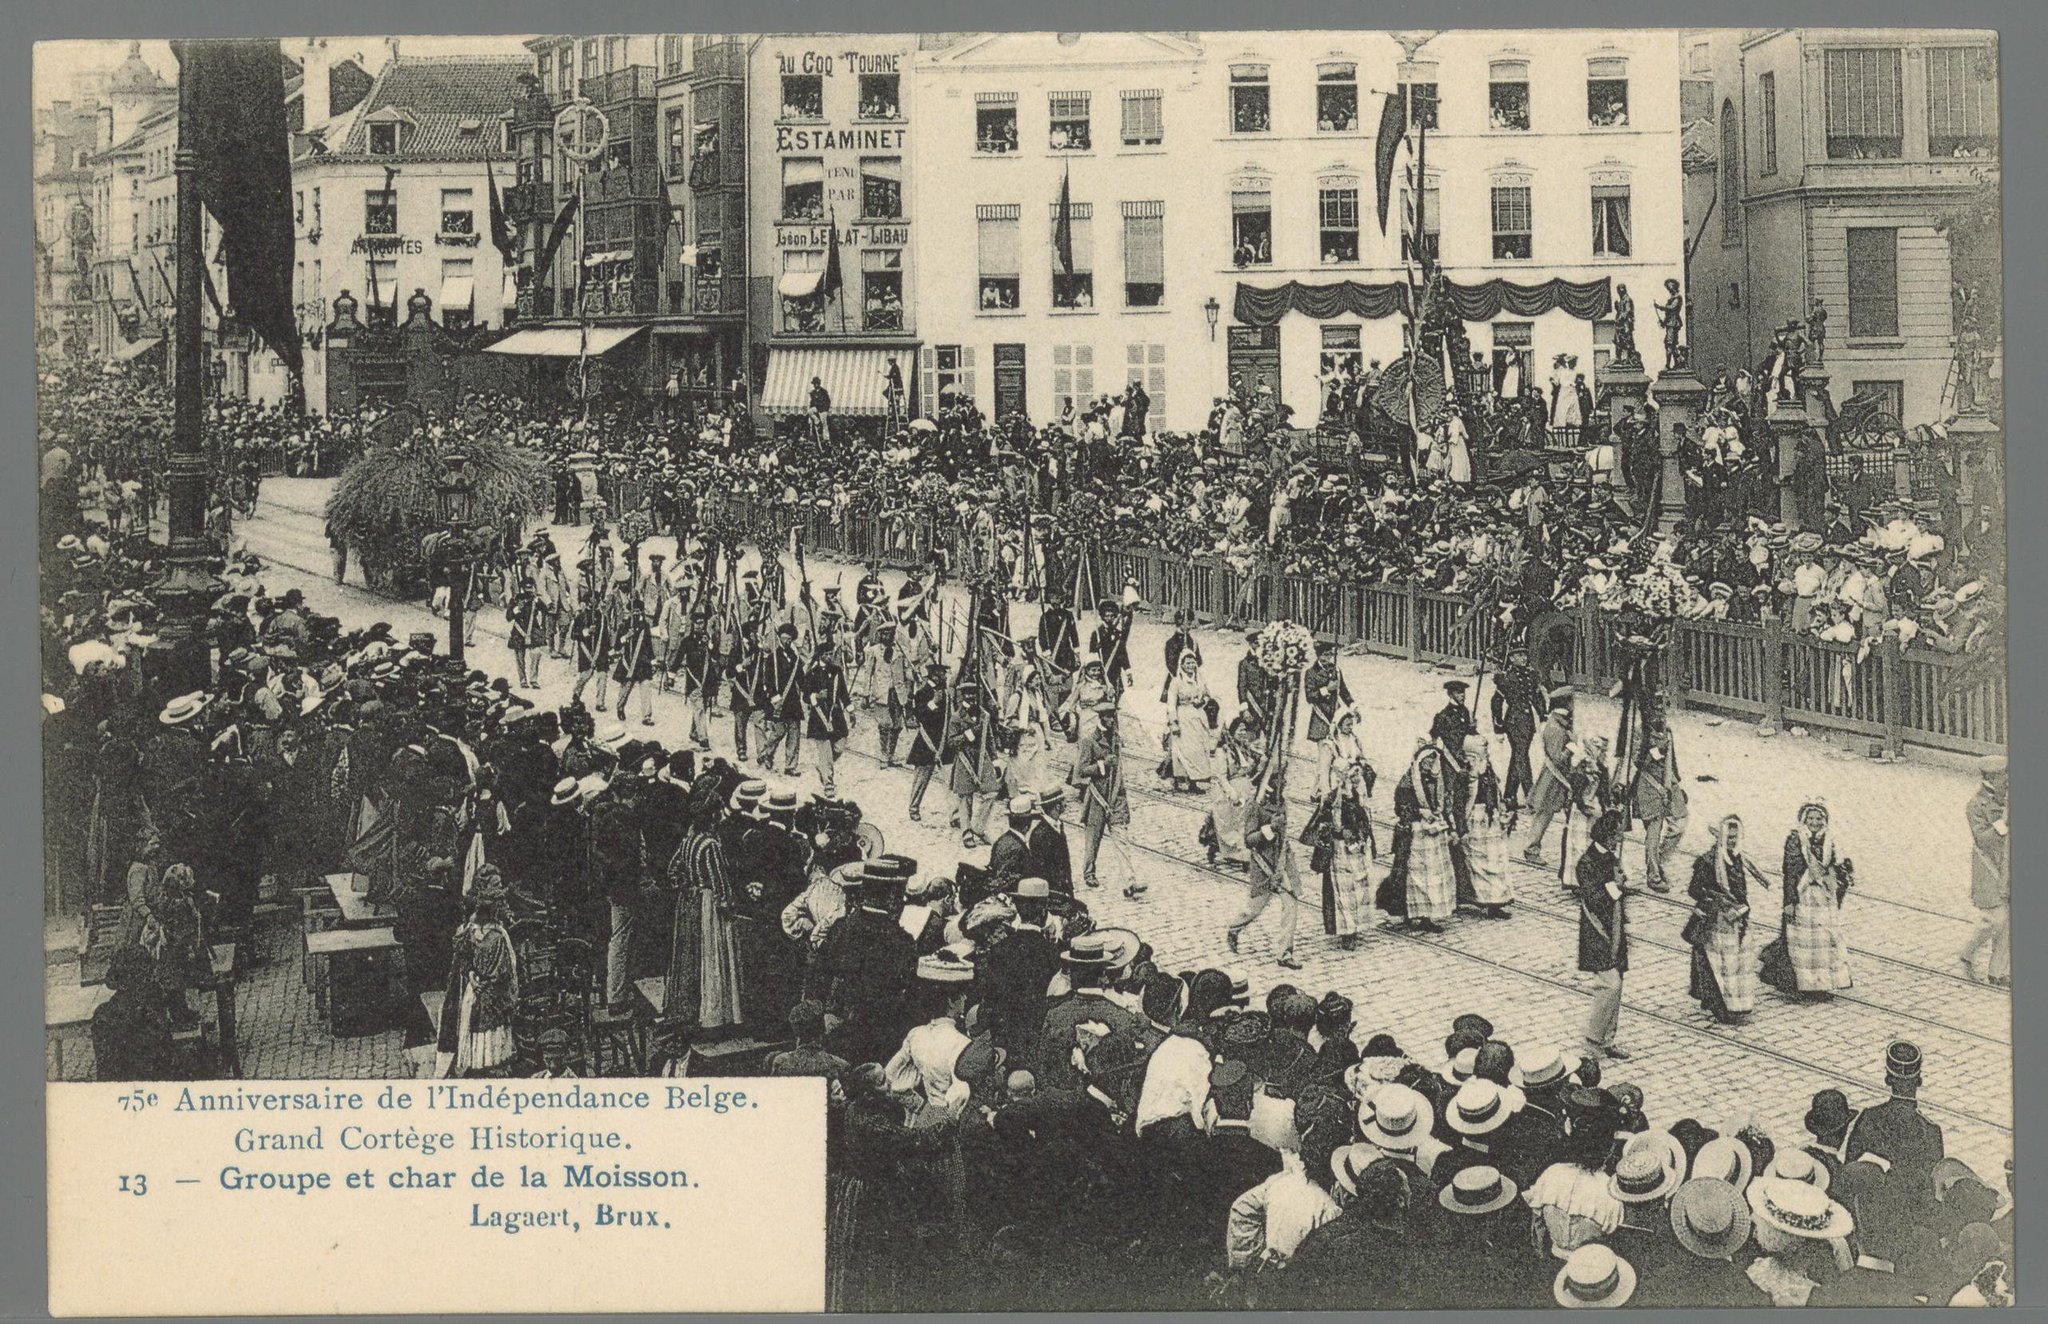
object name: ansichtkaart, prentbriefkaart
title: 75e Anniversaire de l'Indépendance Belge. Grand Cortège Historique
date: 1905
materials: cardboard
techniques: photograph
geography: schaarbeek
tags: city-view, and landscape with man-made constructions (+ city(-scape) with figures, staffage), periodic celebrations, popular feasts, brussels